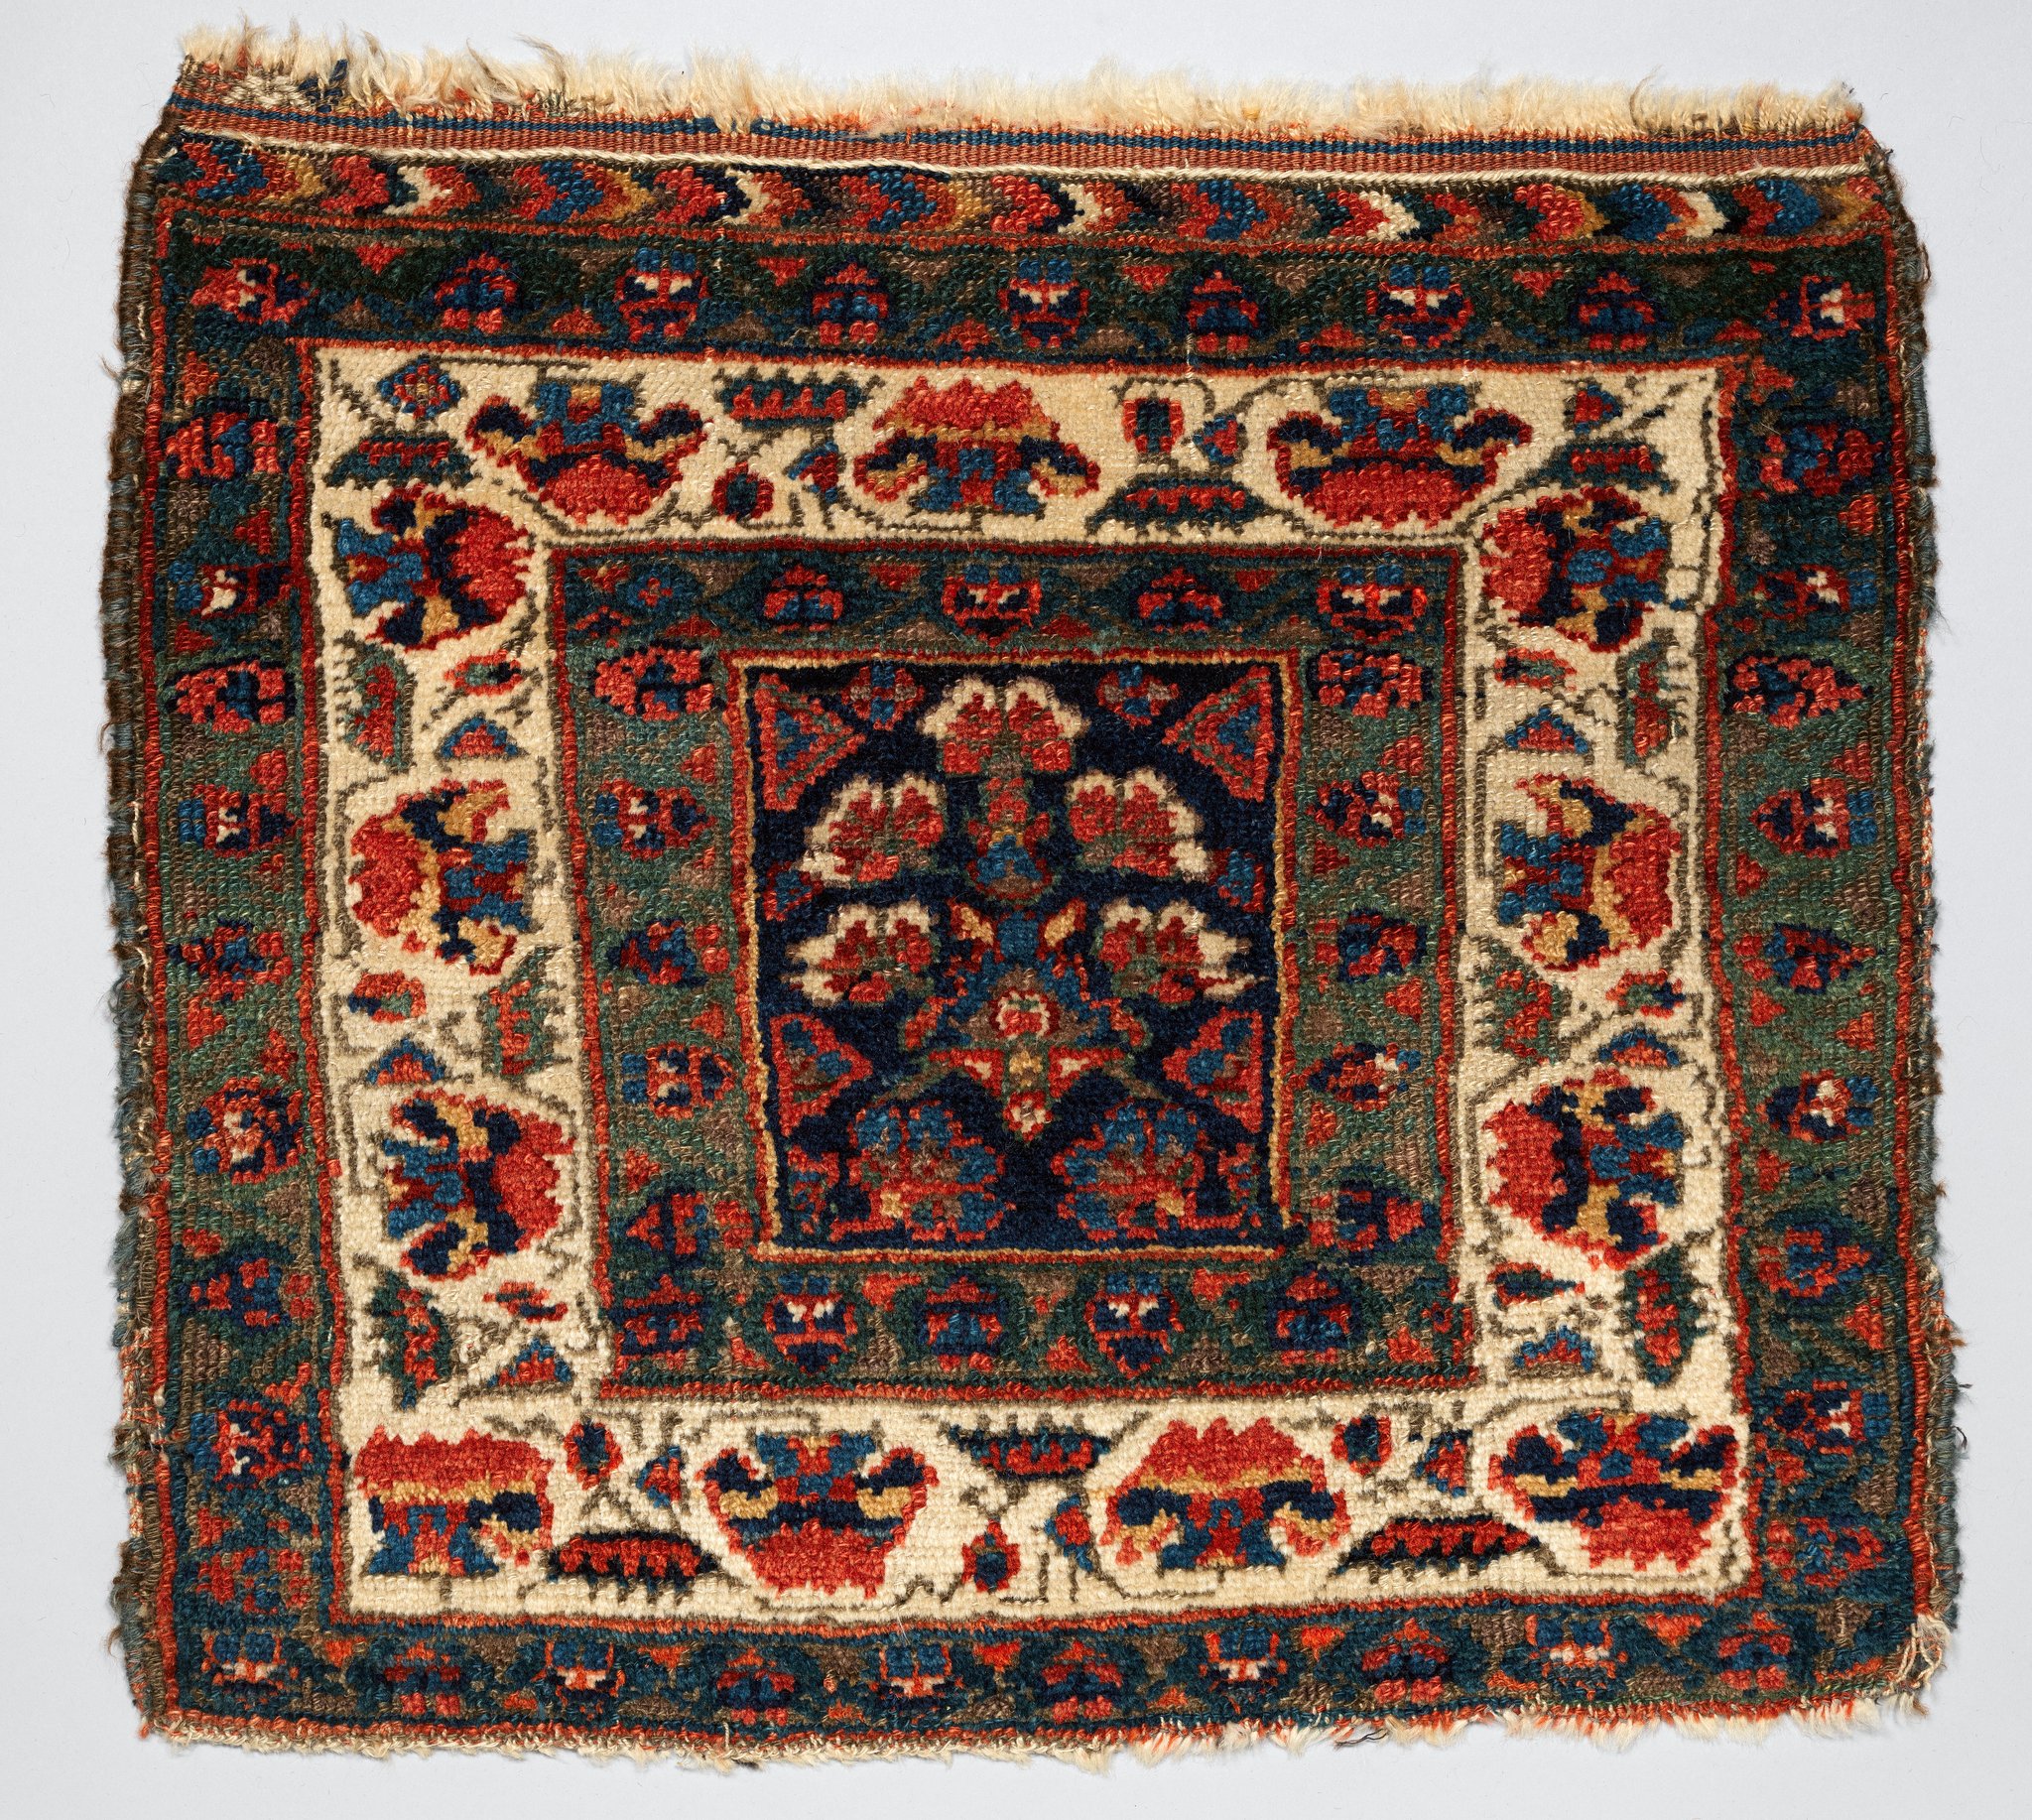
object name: saddle bag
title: Face from Half of Double Saddle Bag (Khorjin)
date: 1801-1900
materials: wool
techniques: asymmetrically knotted pile, weave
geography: iran